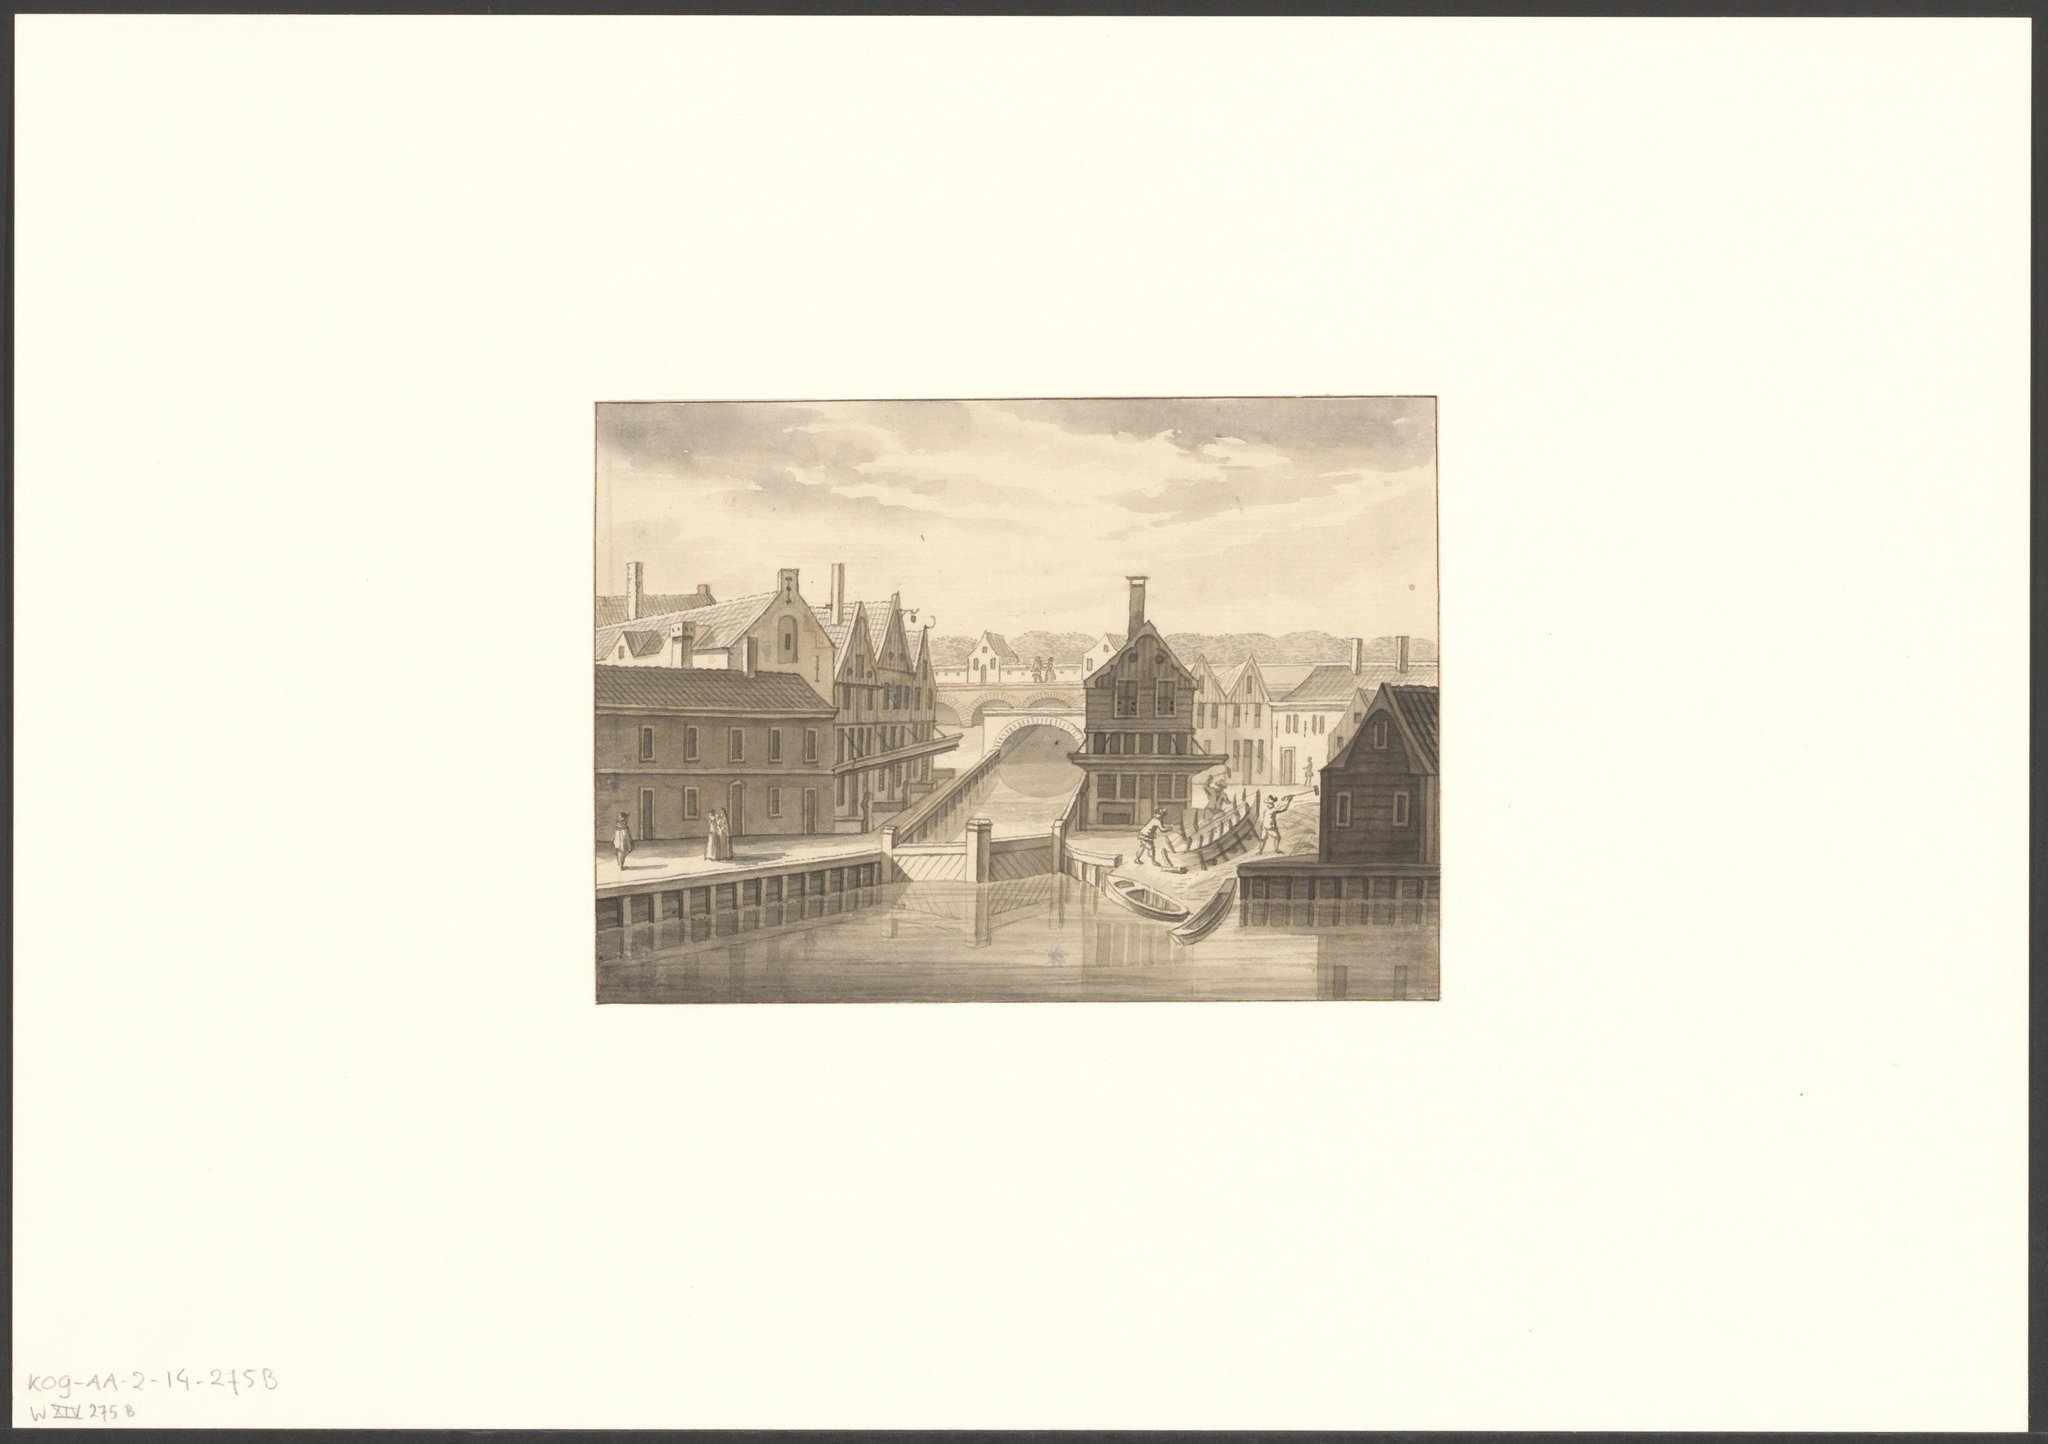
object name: drawing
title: Gezicht op de schutsluis Boerenverdriet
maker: Anonymous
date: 1700-1799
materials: ink, paper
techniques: brush, pen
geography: amsterdam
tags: sluice, weir, city-view in general; 'veduta', canal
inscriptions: inscription: ‘'t Boeren verdriet.’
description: Tekening binnen de Atlas Van Eck ingedeeld op wijknummer 14.